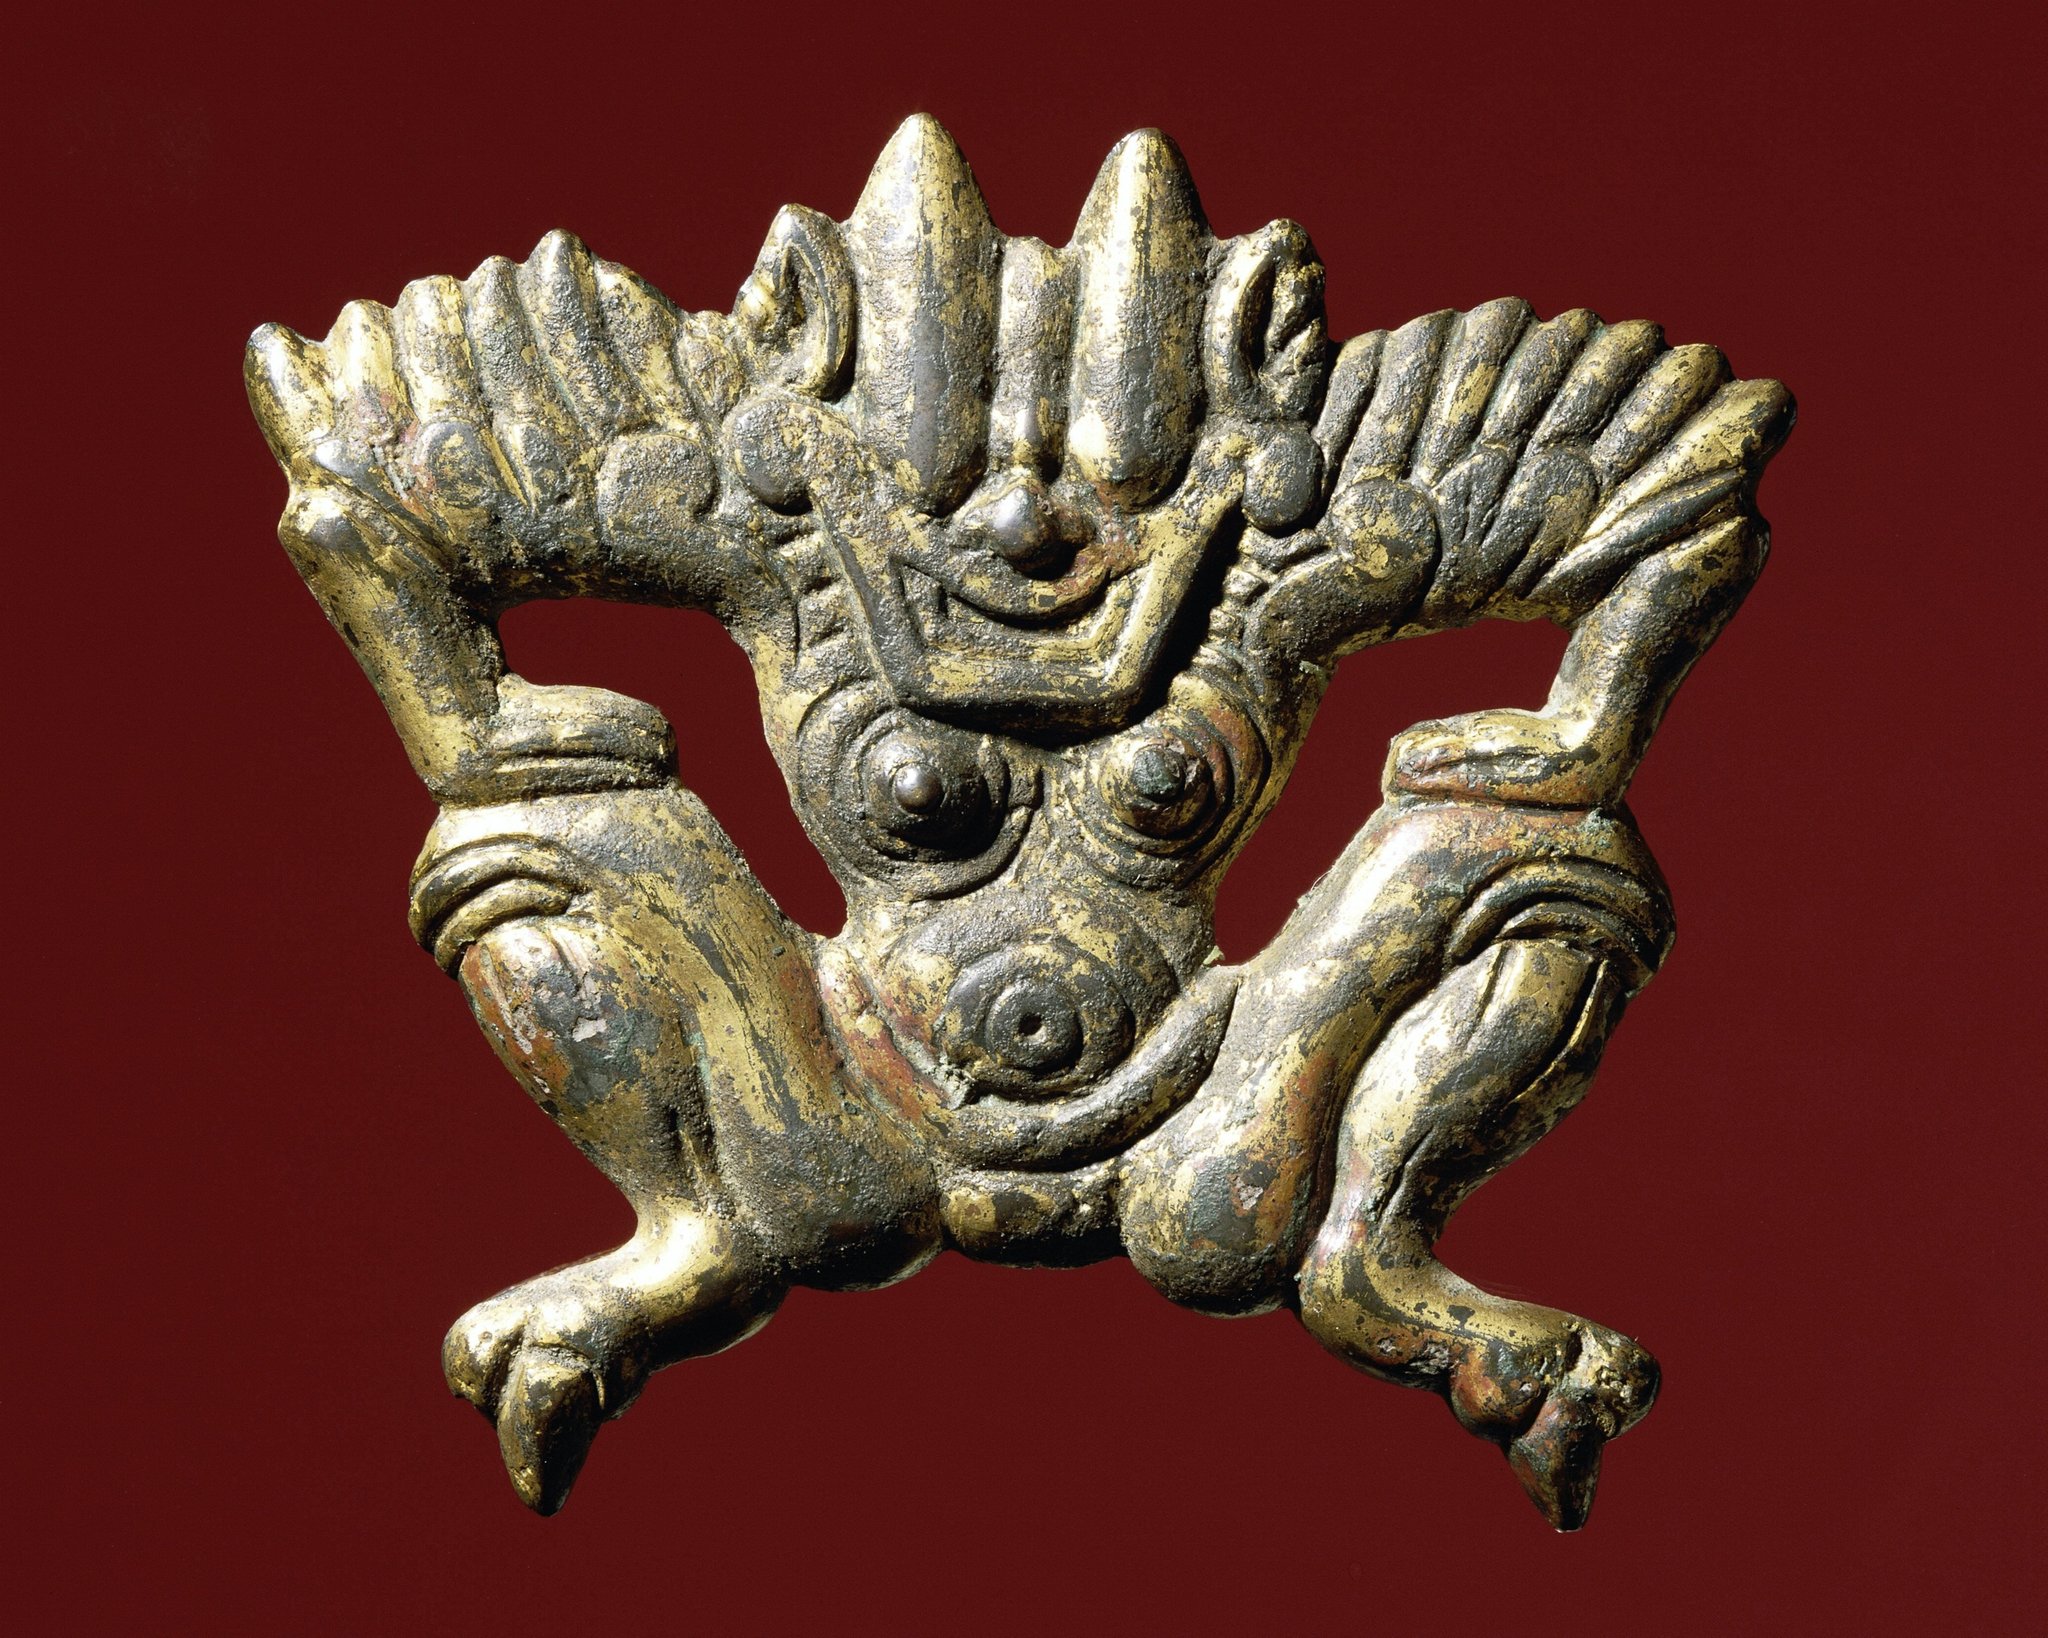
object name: appliqué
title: Applique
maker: Anonymous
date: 500-600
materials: bronze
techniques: gilding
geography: china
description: Ornament in the form of a demon. China. Northern Wei period (386 - 534). Gilt bronze. Given by E. Gutmann.